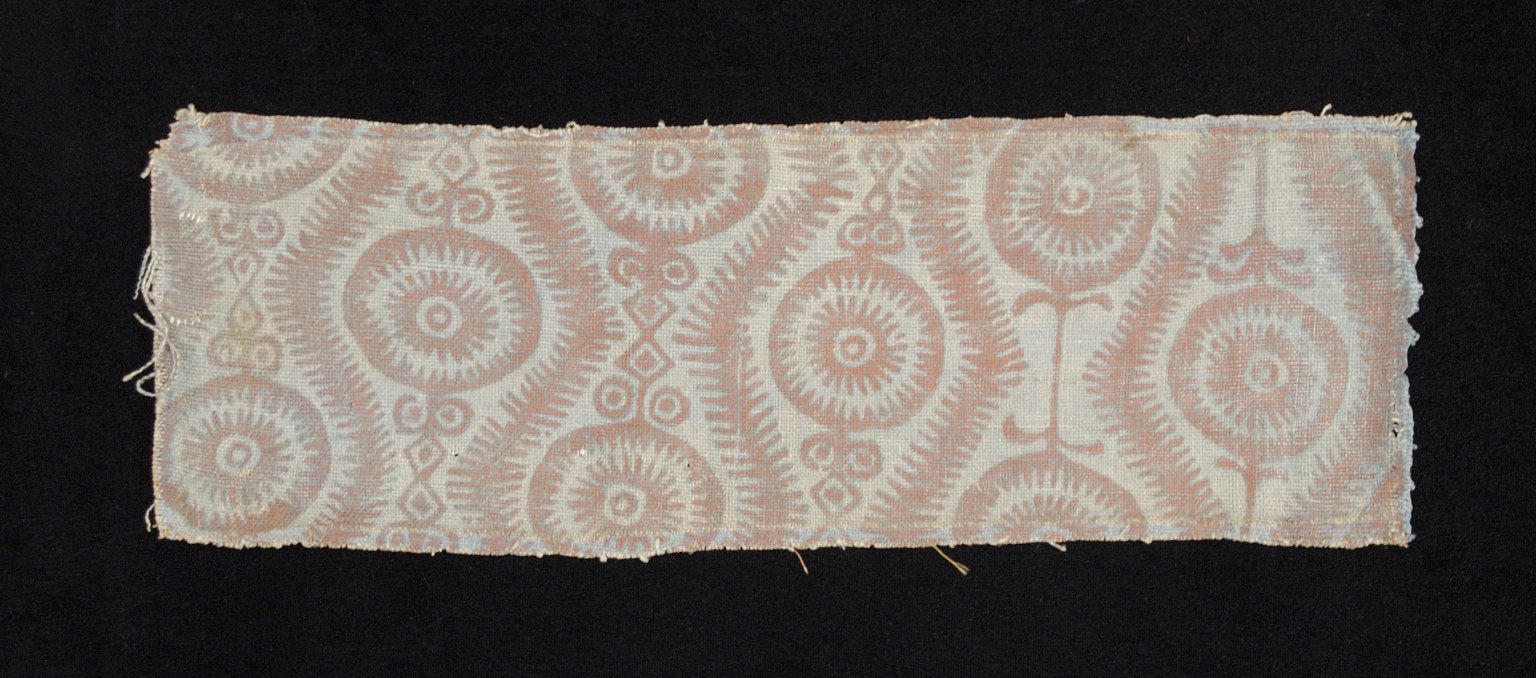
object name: textile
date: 1700-1899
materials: linen